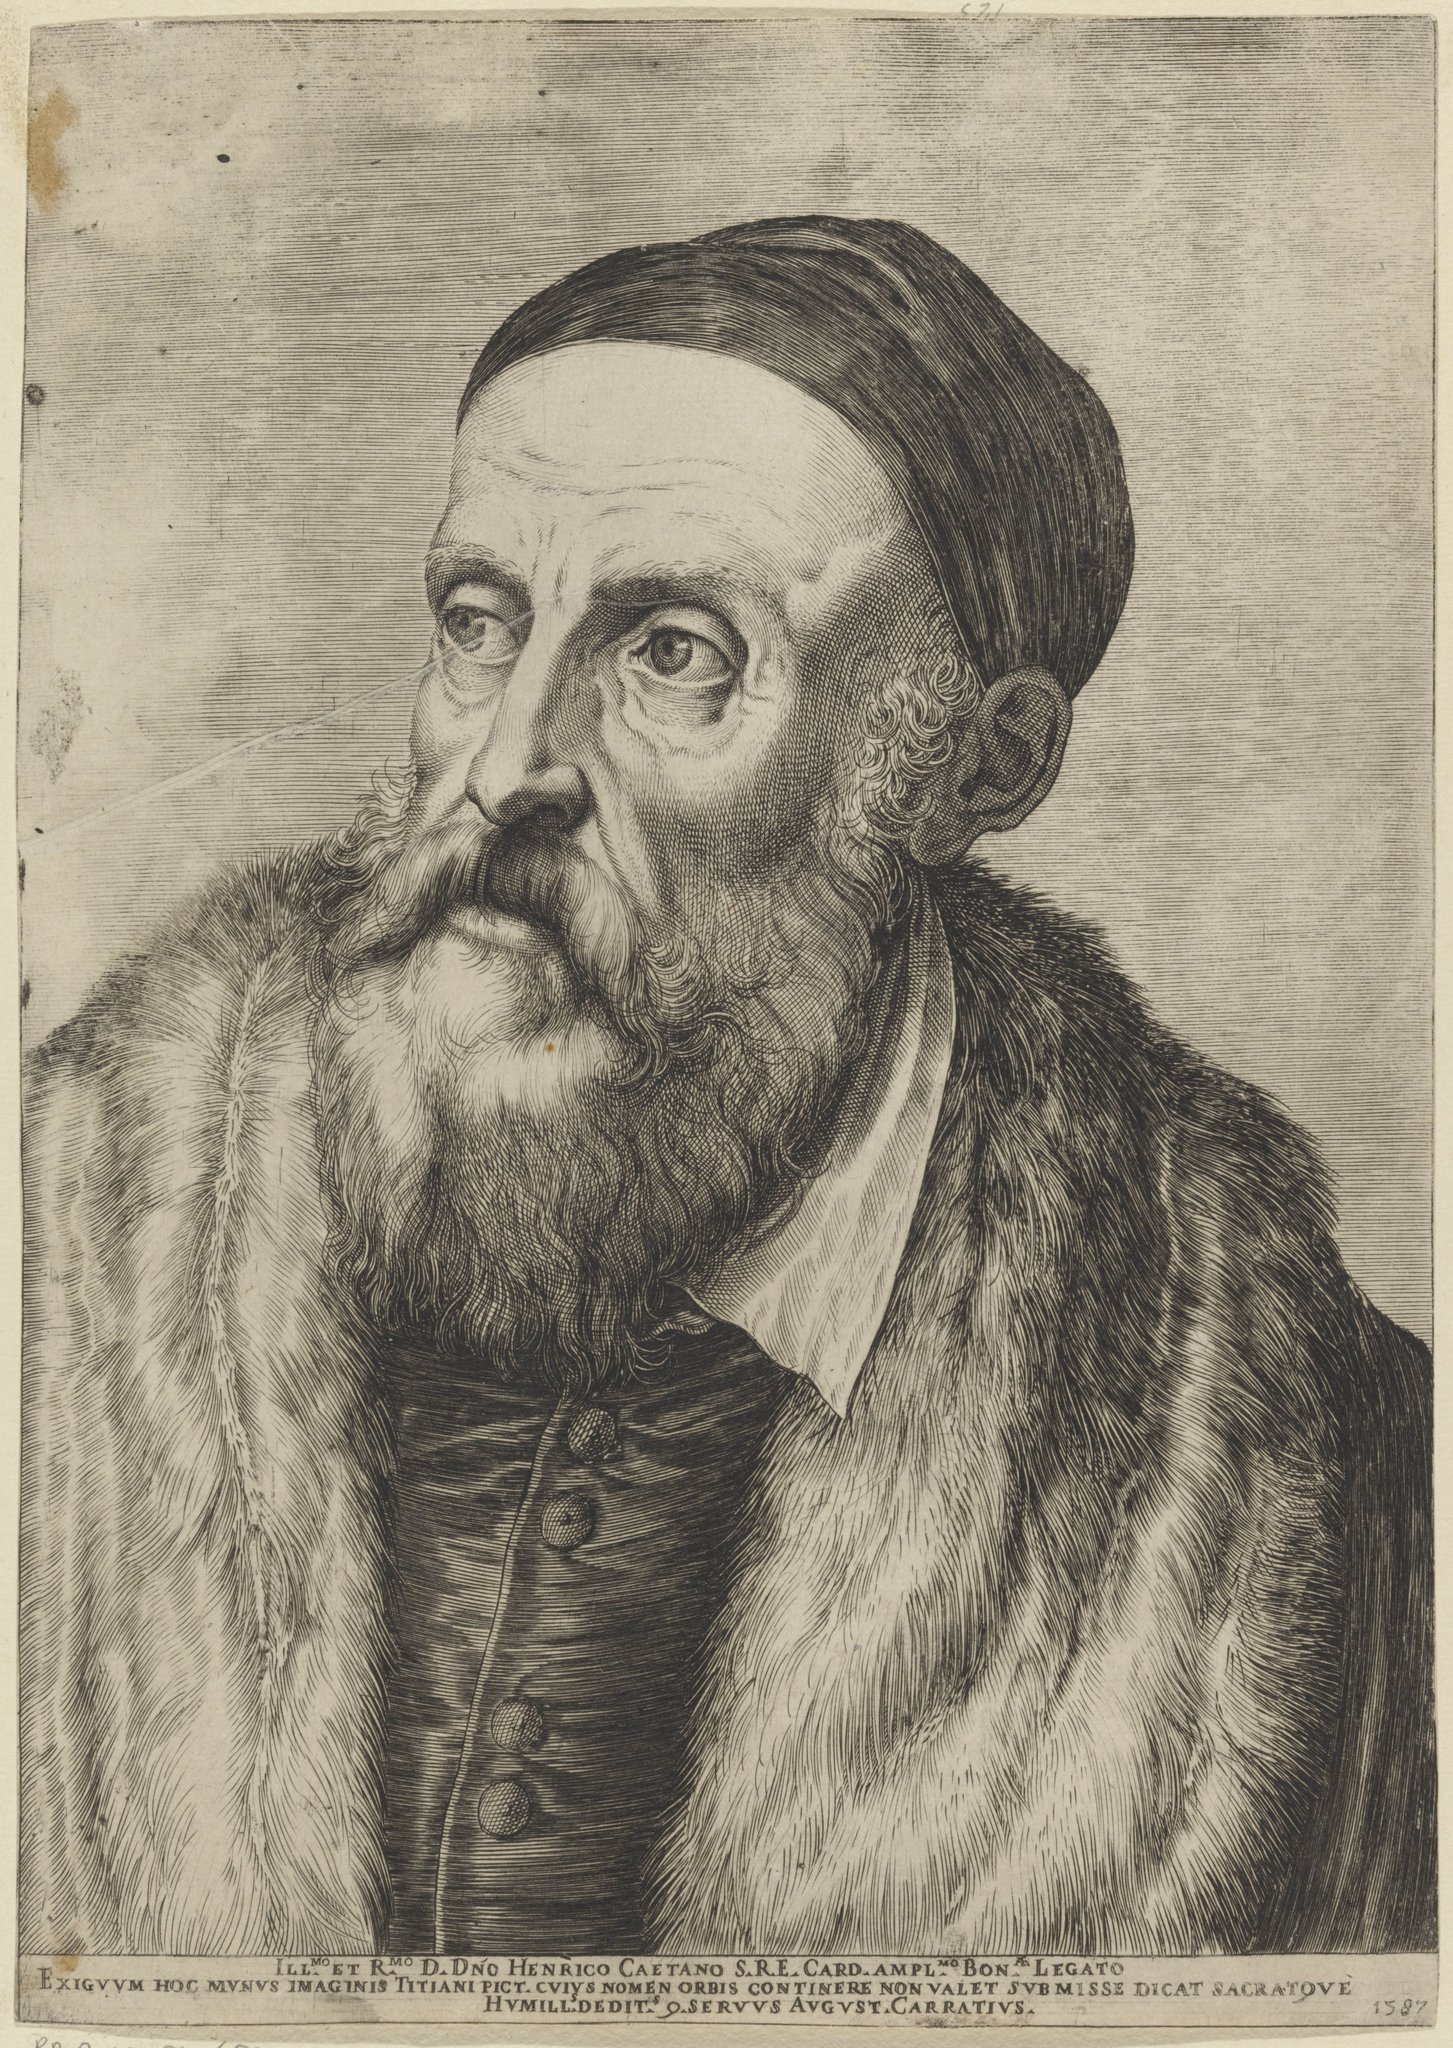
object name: print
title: Portret van schilder Titiaan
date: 1587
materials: paper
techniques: engraving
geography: italy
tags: venice, titiaan, historical persons, portrait, self-portrait of artist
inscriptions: date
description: Naar geschilderd zelfportret van Titiaan in de Staatliche Museen Preussischer Kulturbesitz, Gemäldegalerie te Berlijn.